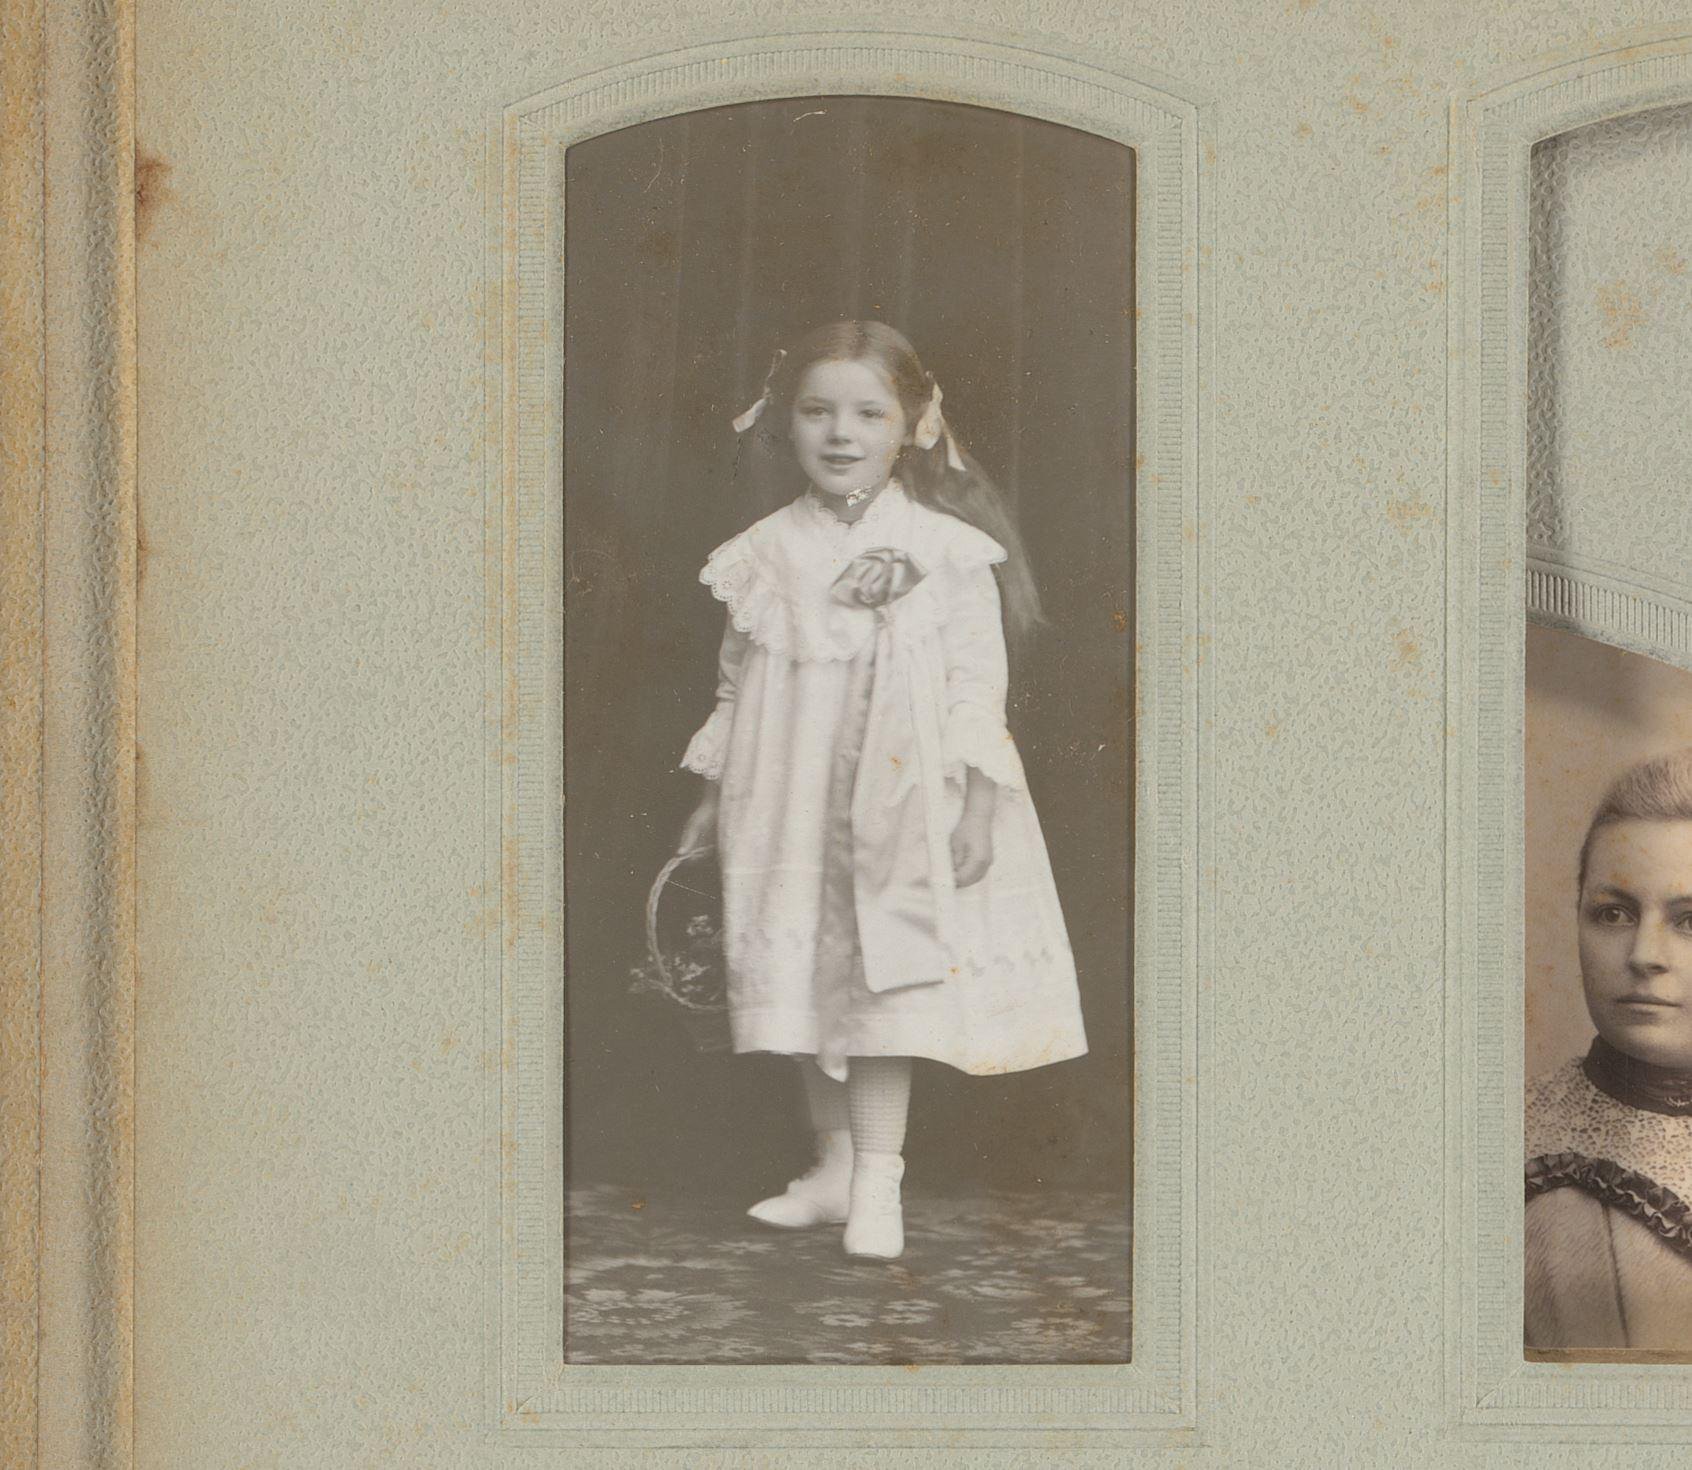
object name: photograph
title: Portret van een onbekend meisje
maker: Anonymous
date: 1890-1910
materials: paper, cardboard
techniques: gelatin silver print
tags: girl (child between toddler and youth), anonymous historical person portrayed